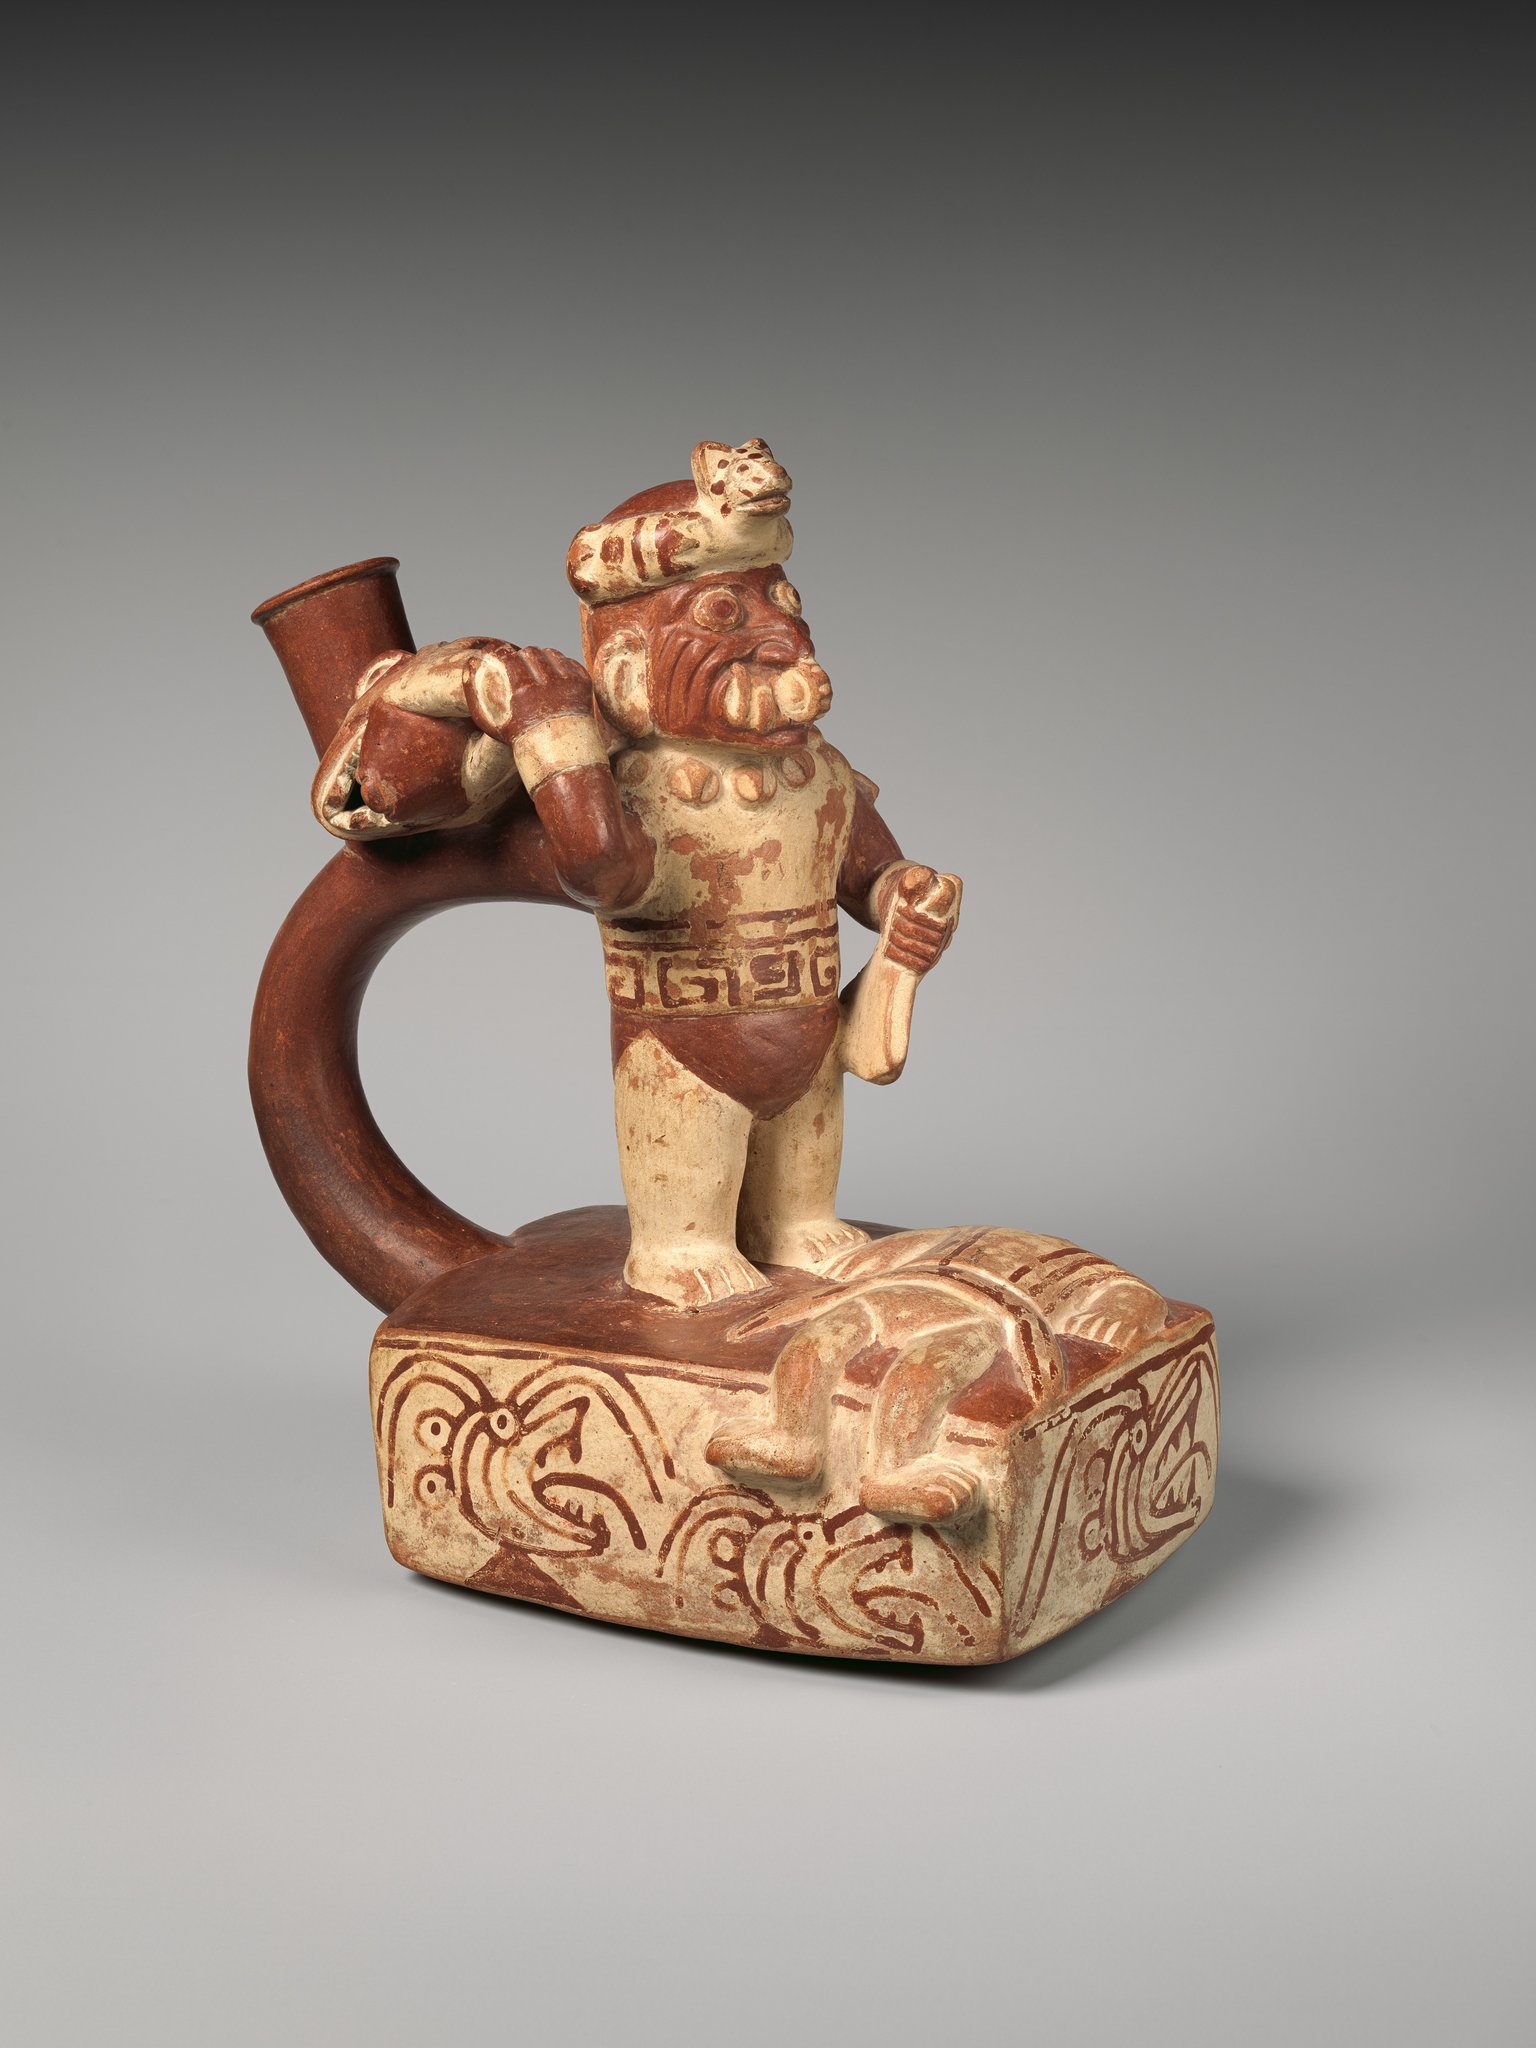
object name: bottle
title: Stirrup-spout bottle with decapitation scene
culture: moche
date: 200-500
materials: ceramic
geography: peru